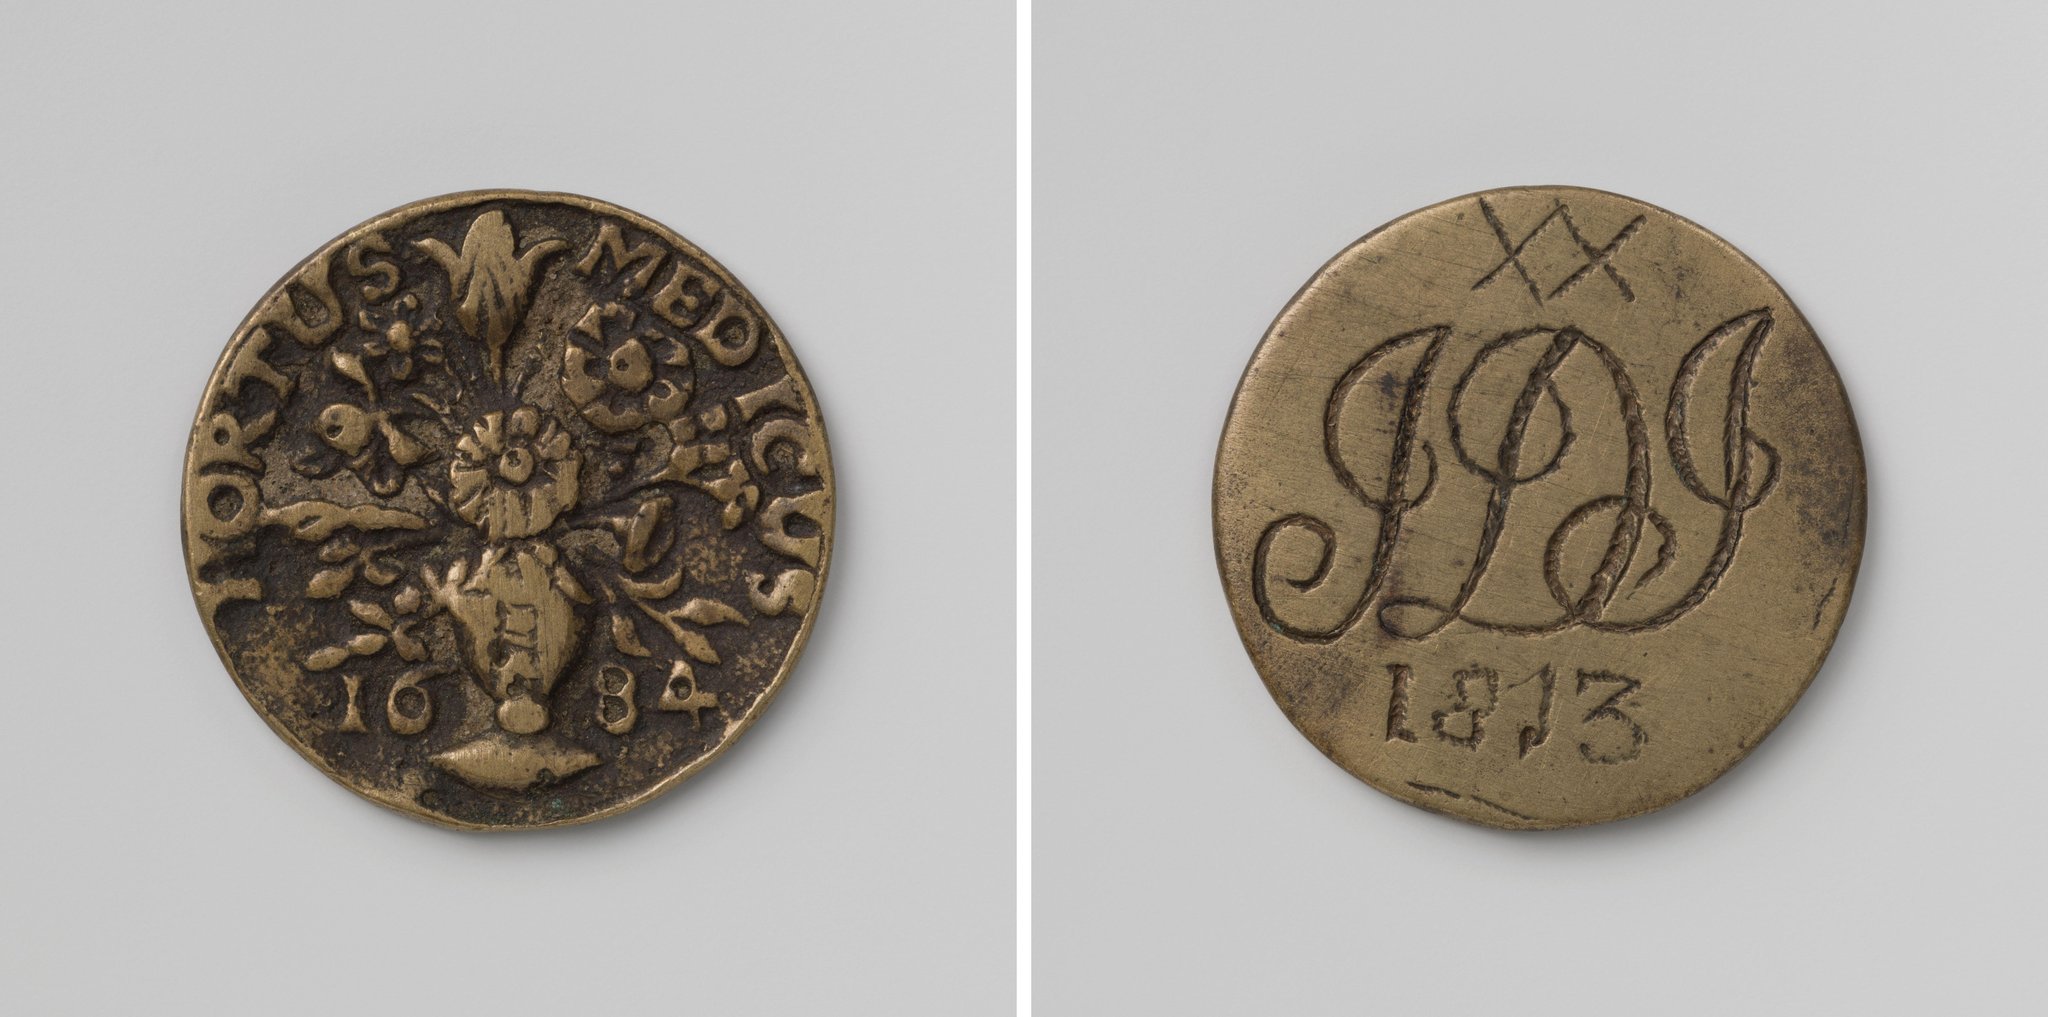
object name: toegangspenning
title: Collegium Medicum te Amsterdam, toegangspenning voor de hortus medicus voor apothekersleerling J.D.J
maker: Anonymous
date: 1813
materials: brass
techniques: casting, engraving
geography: amsterdam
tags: amsterdam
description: Messing penning. Voorzijde: vaas met bloemen tussen jaartal; op vaas: wapenschild binnen omschrift. Keerzijde: opschrift onder twee kruisjes boven jaartal